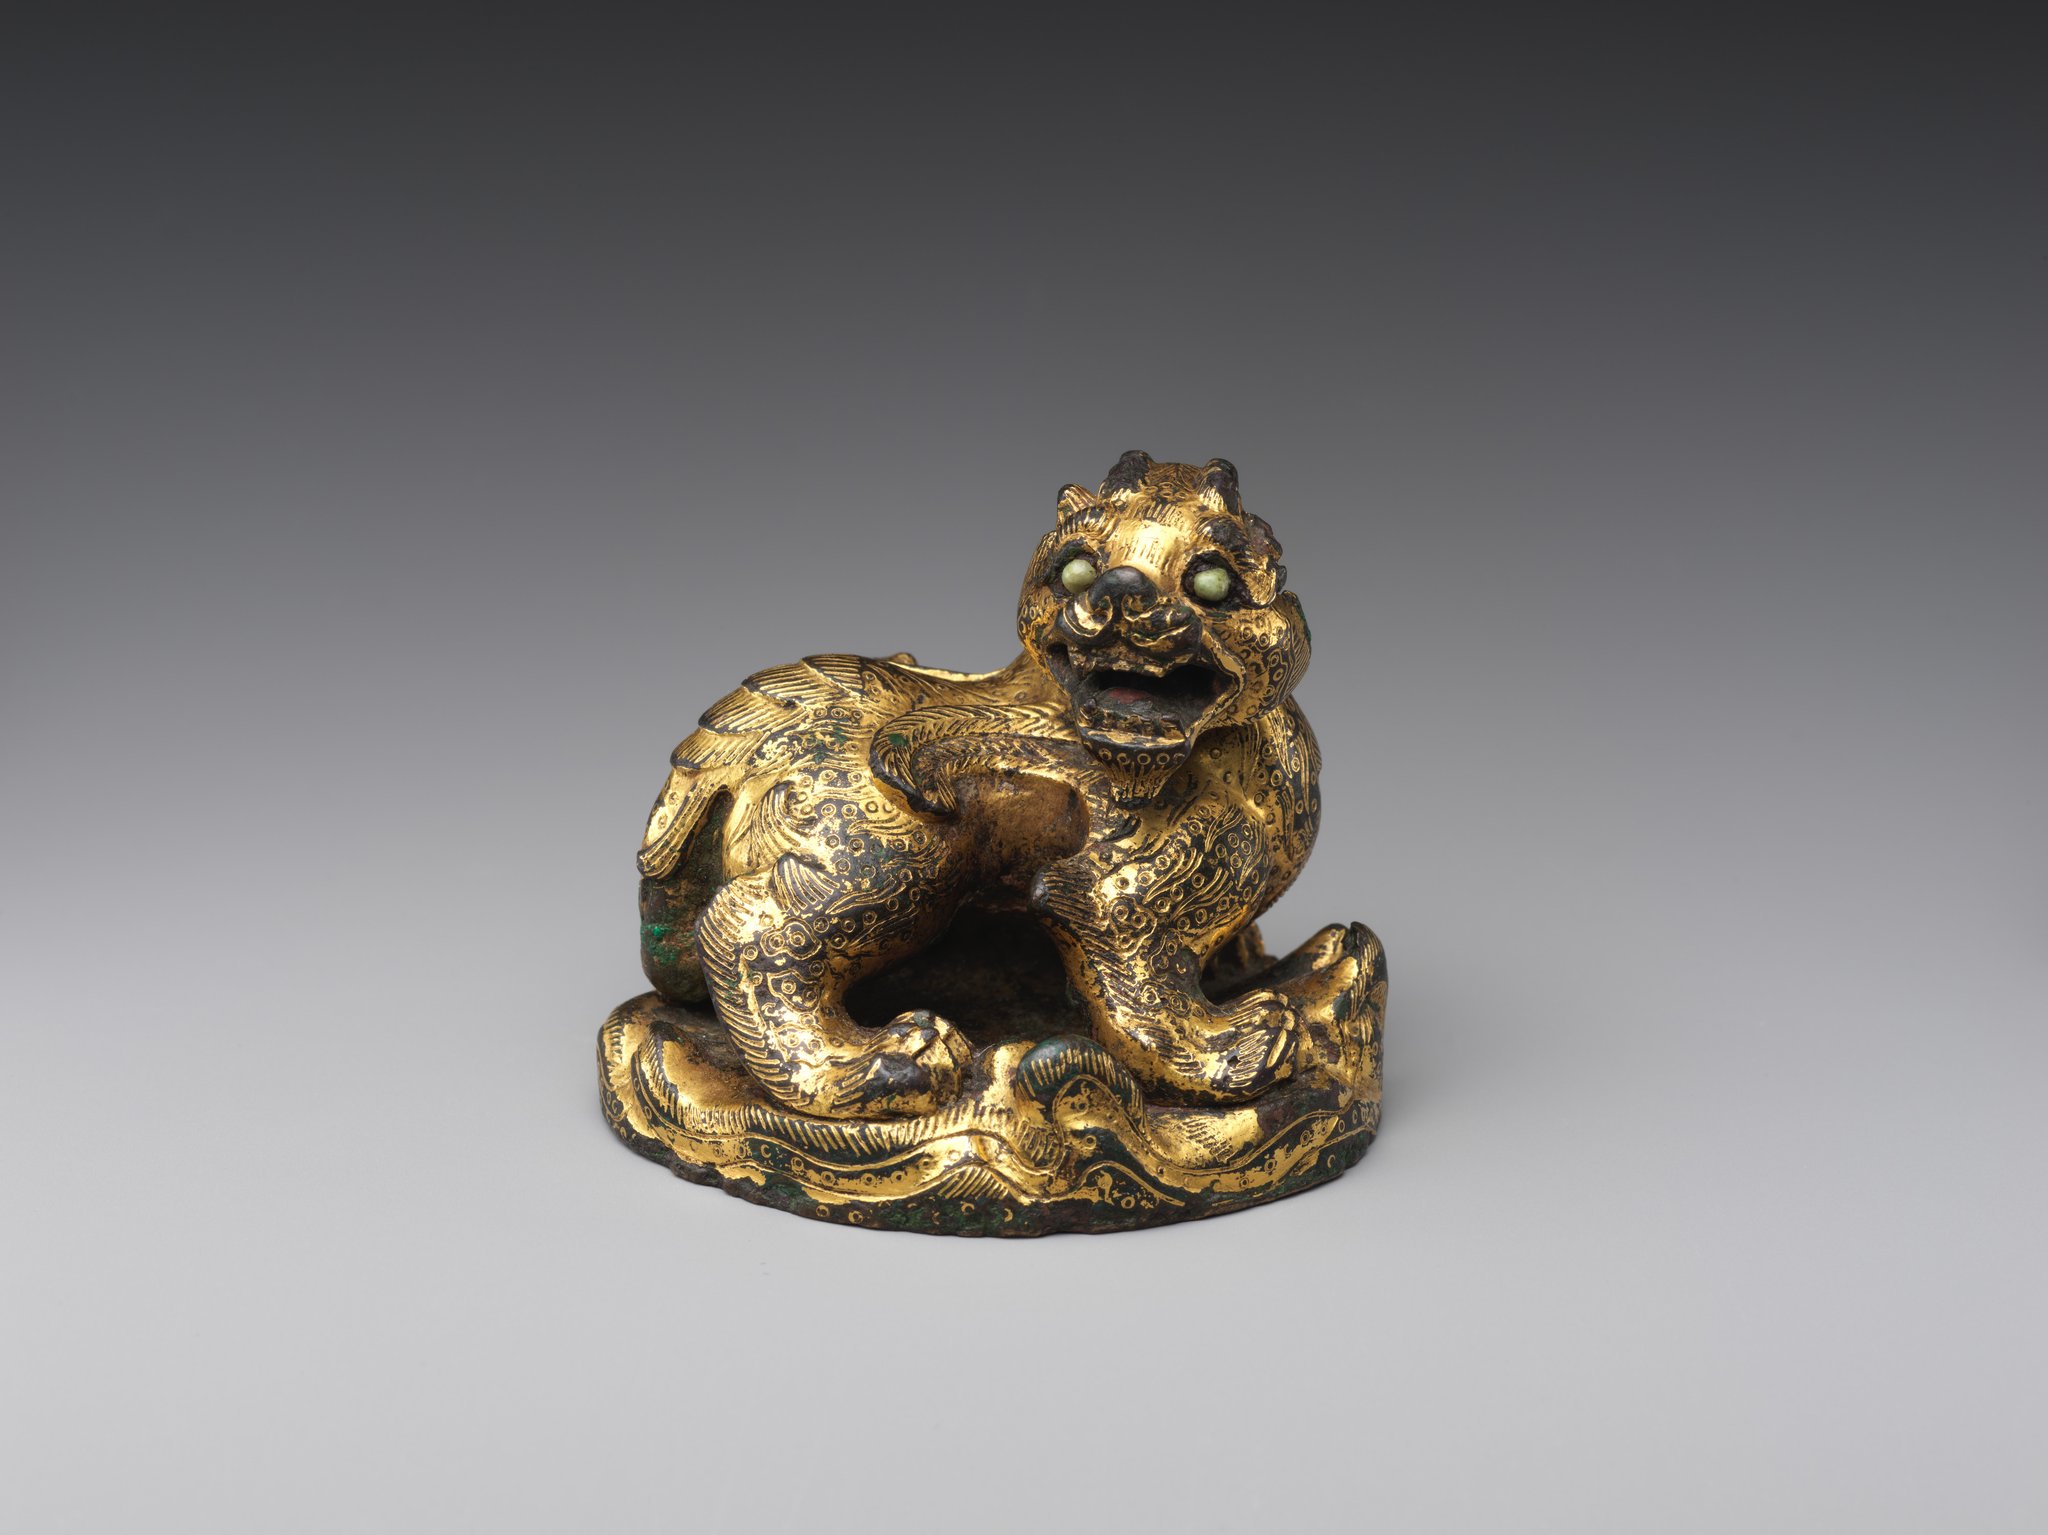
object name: mat weight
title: Weight in the shape of a chimera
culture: chinese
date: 200-101 BCE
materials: bronze, gold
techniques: gilding, inlay